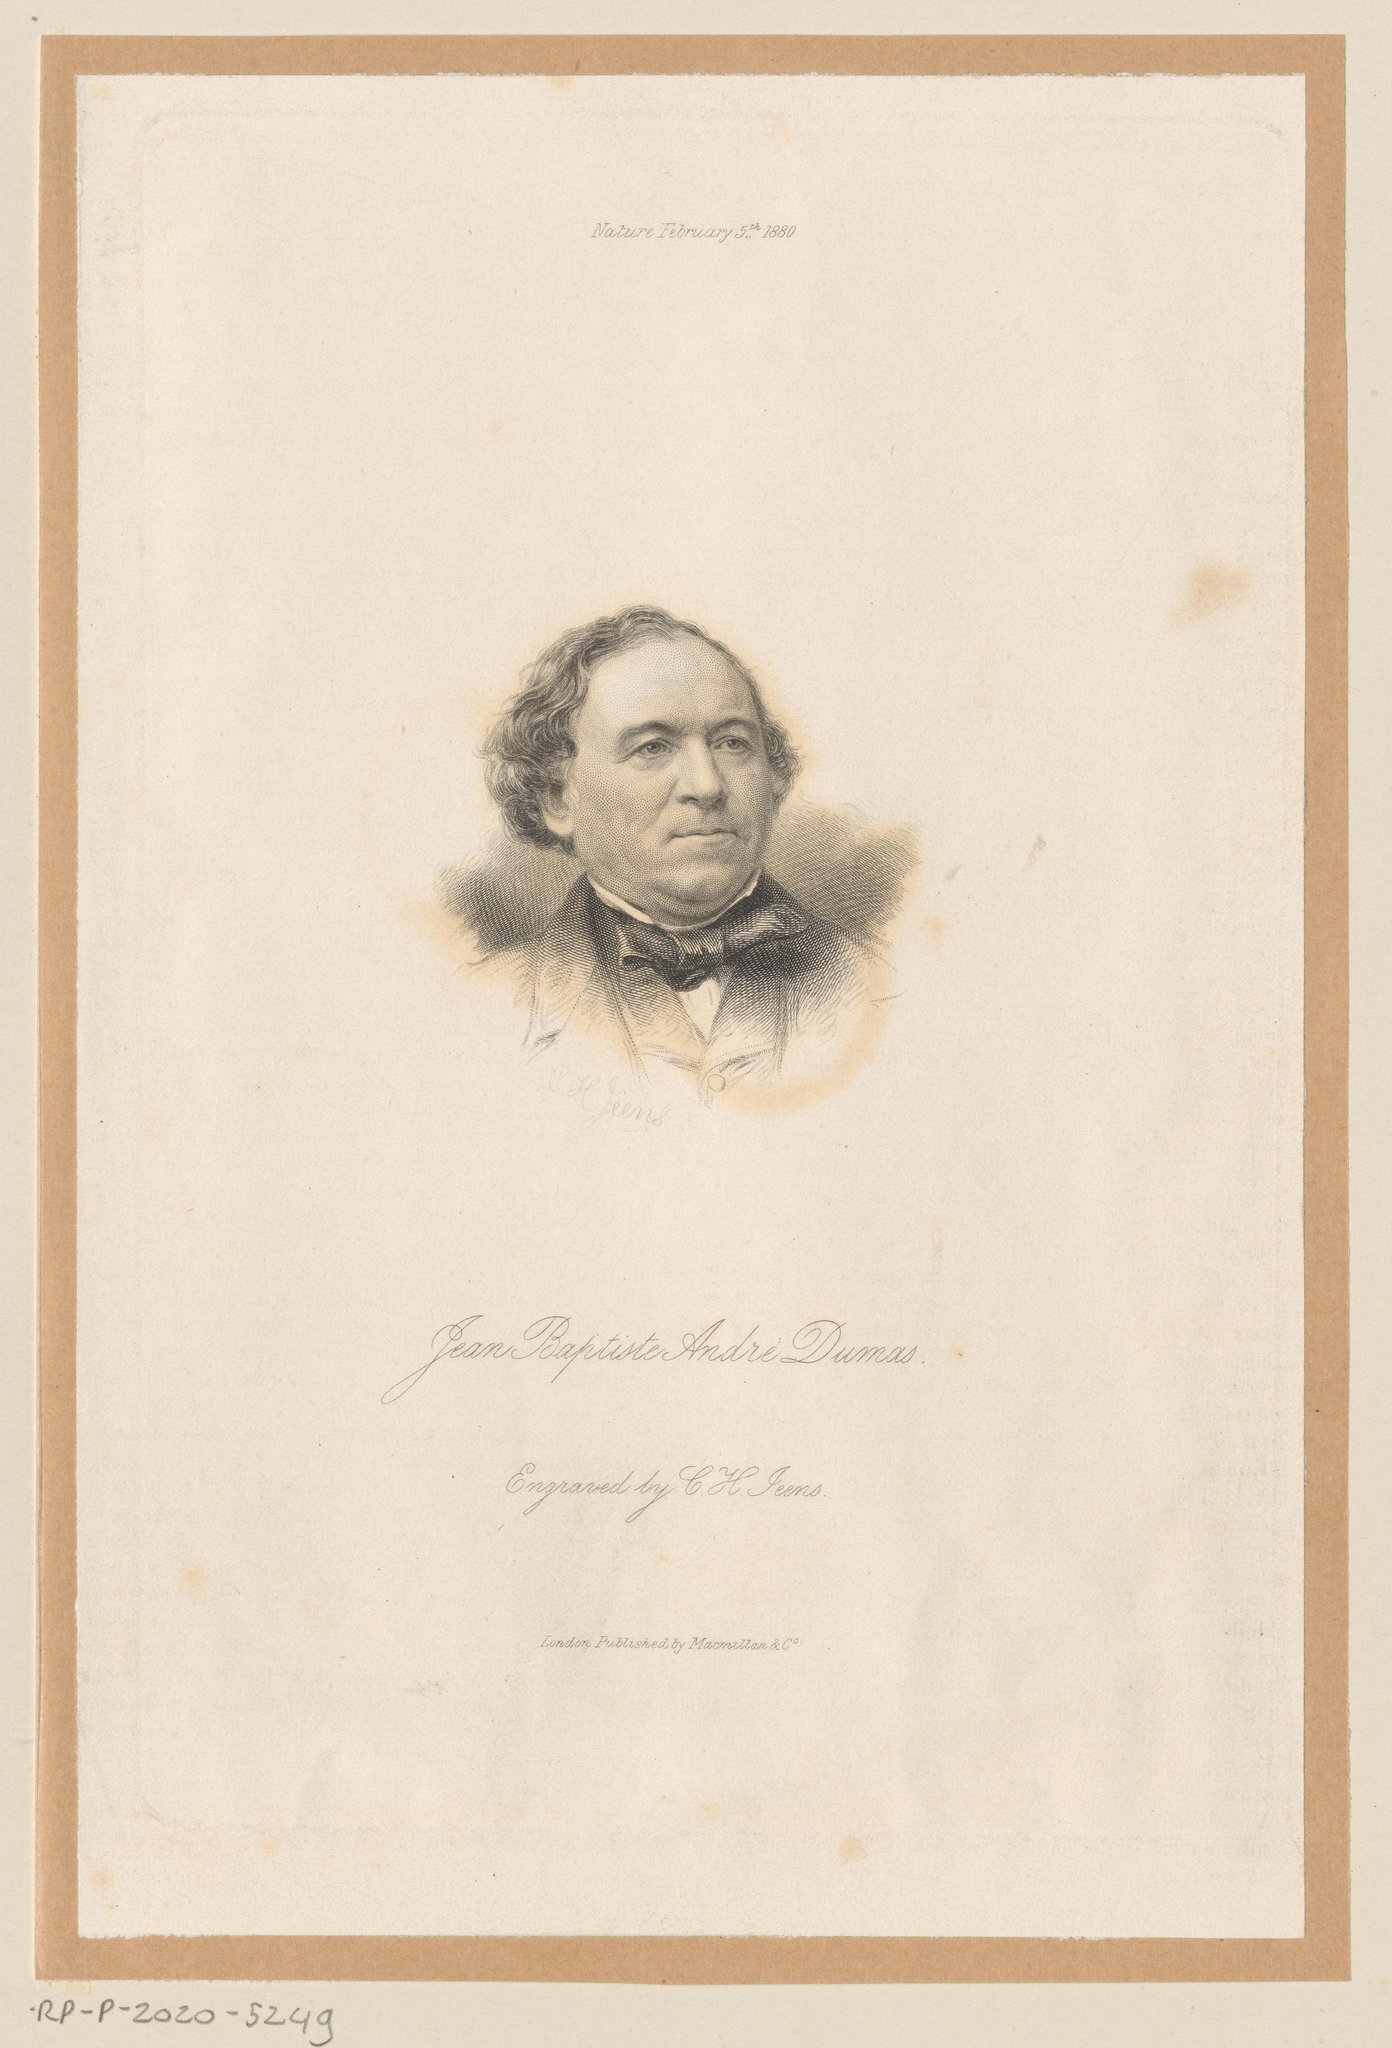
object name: print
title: Portret van Jean-Baptiste Dumas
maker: charles henry jeens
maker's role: print maker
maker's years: 1827-1879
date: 1880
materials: paper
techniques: engraving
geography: london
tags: aspects of science in general, historical persons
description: Prent uit: Nature 21 (1880), nr. 536, 5 februari 1880.